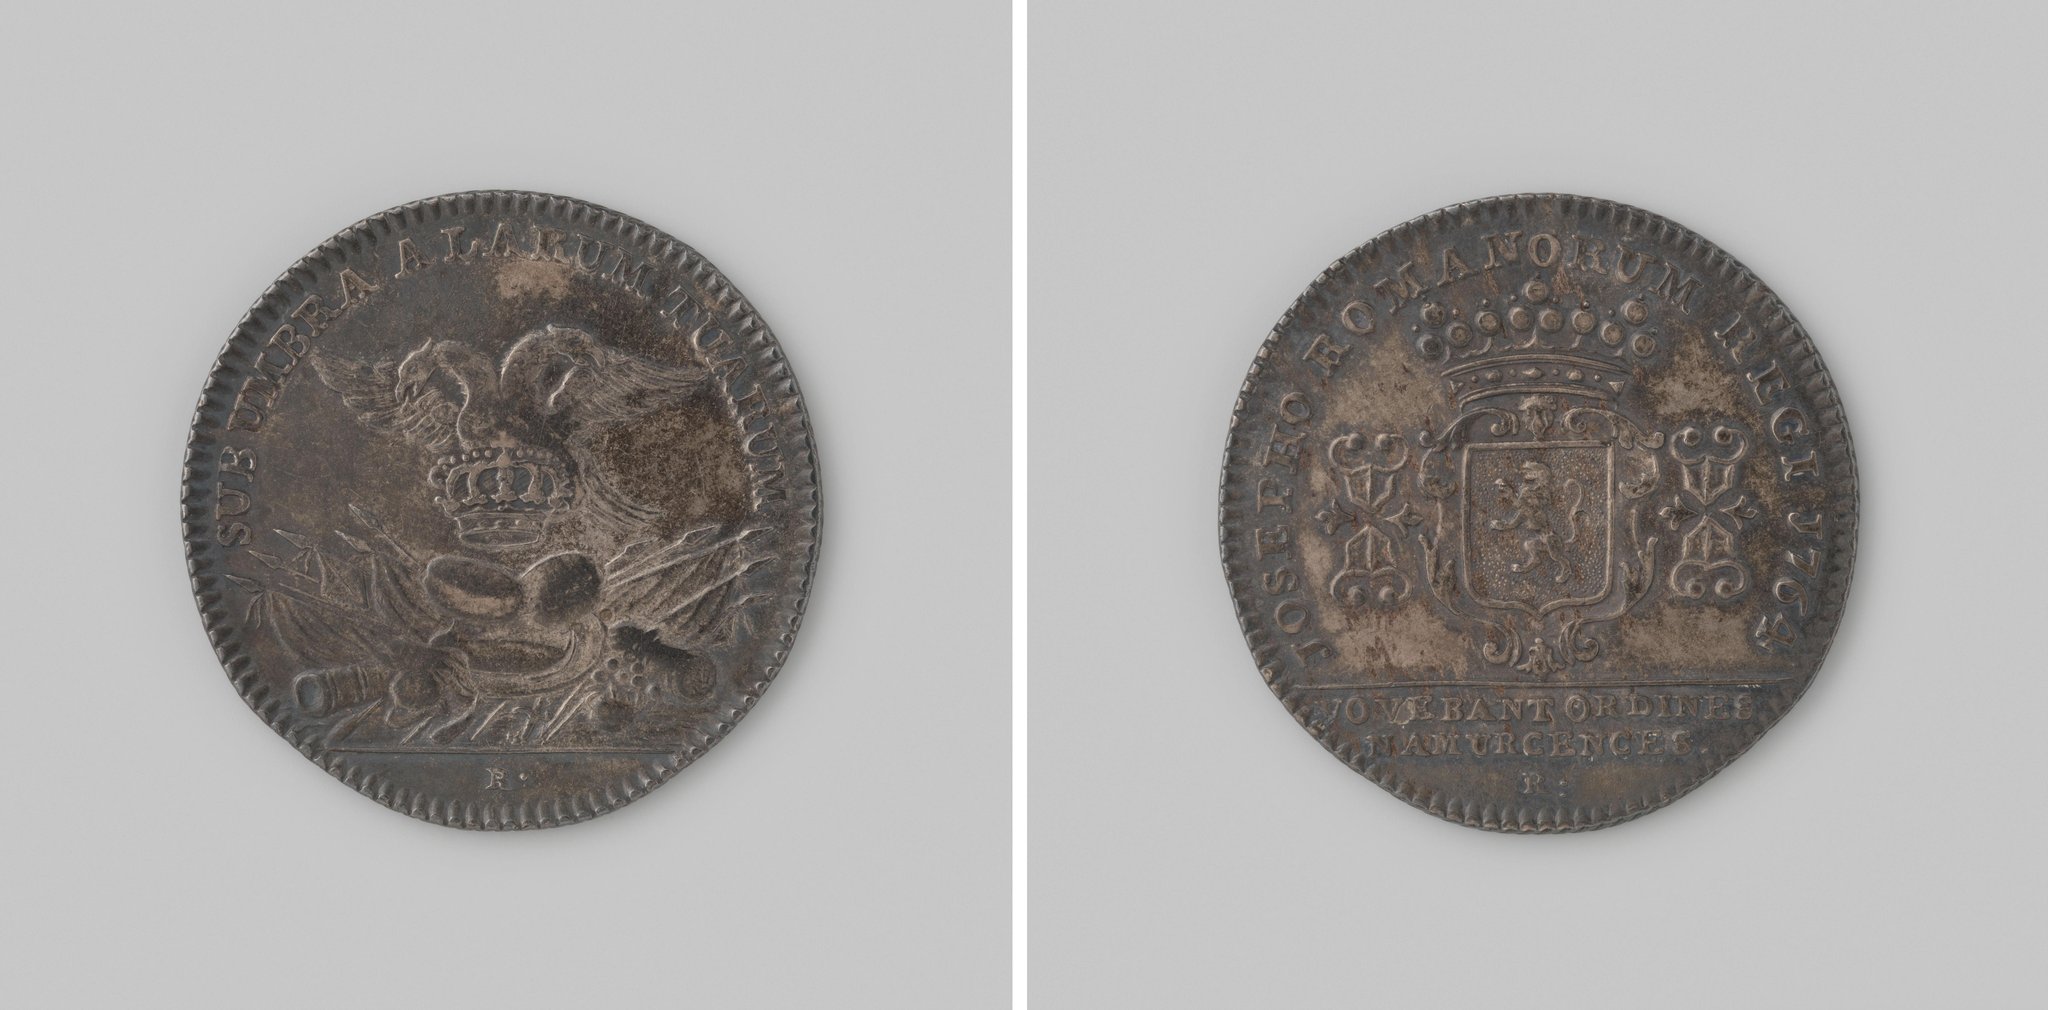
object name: history medal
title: Inhuldiging van Keizer Joseph te Namen 1764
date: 1764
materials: silver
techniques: striking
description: Zilveren penning, op de voorzijde een aanvliegende adelaar die een kroon op een trofee legt, met omschrift, op de keerzijde het gekroonde wapenschild van Namen op cartouche tussen twee vuurijzers, met omschrift en afsnedetekst.